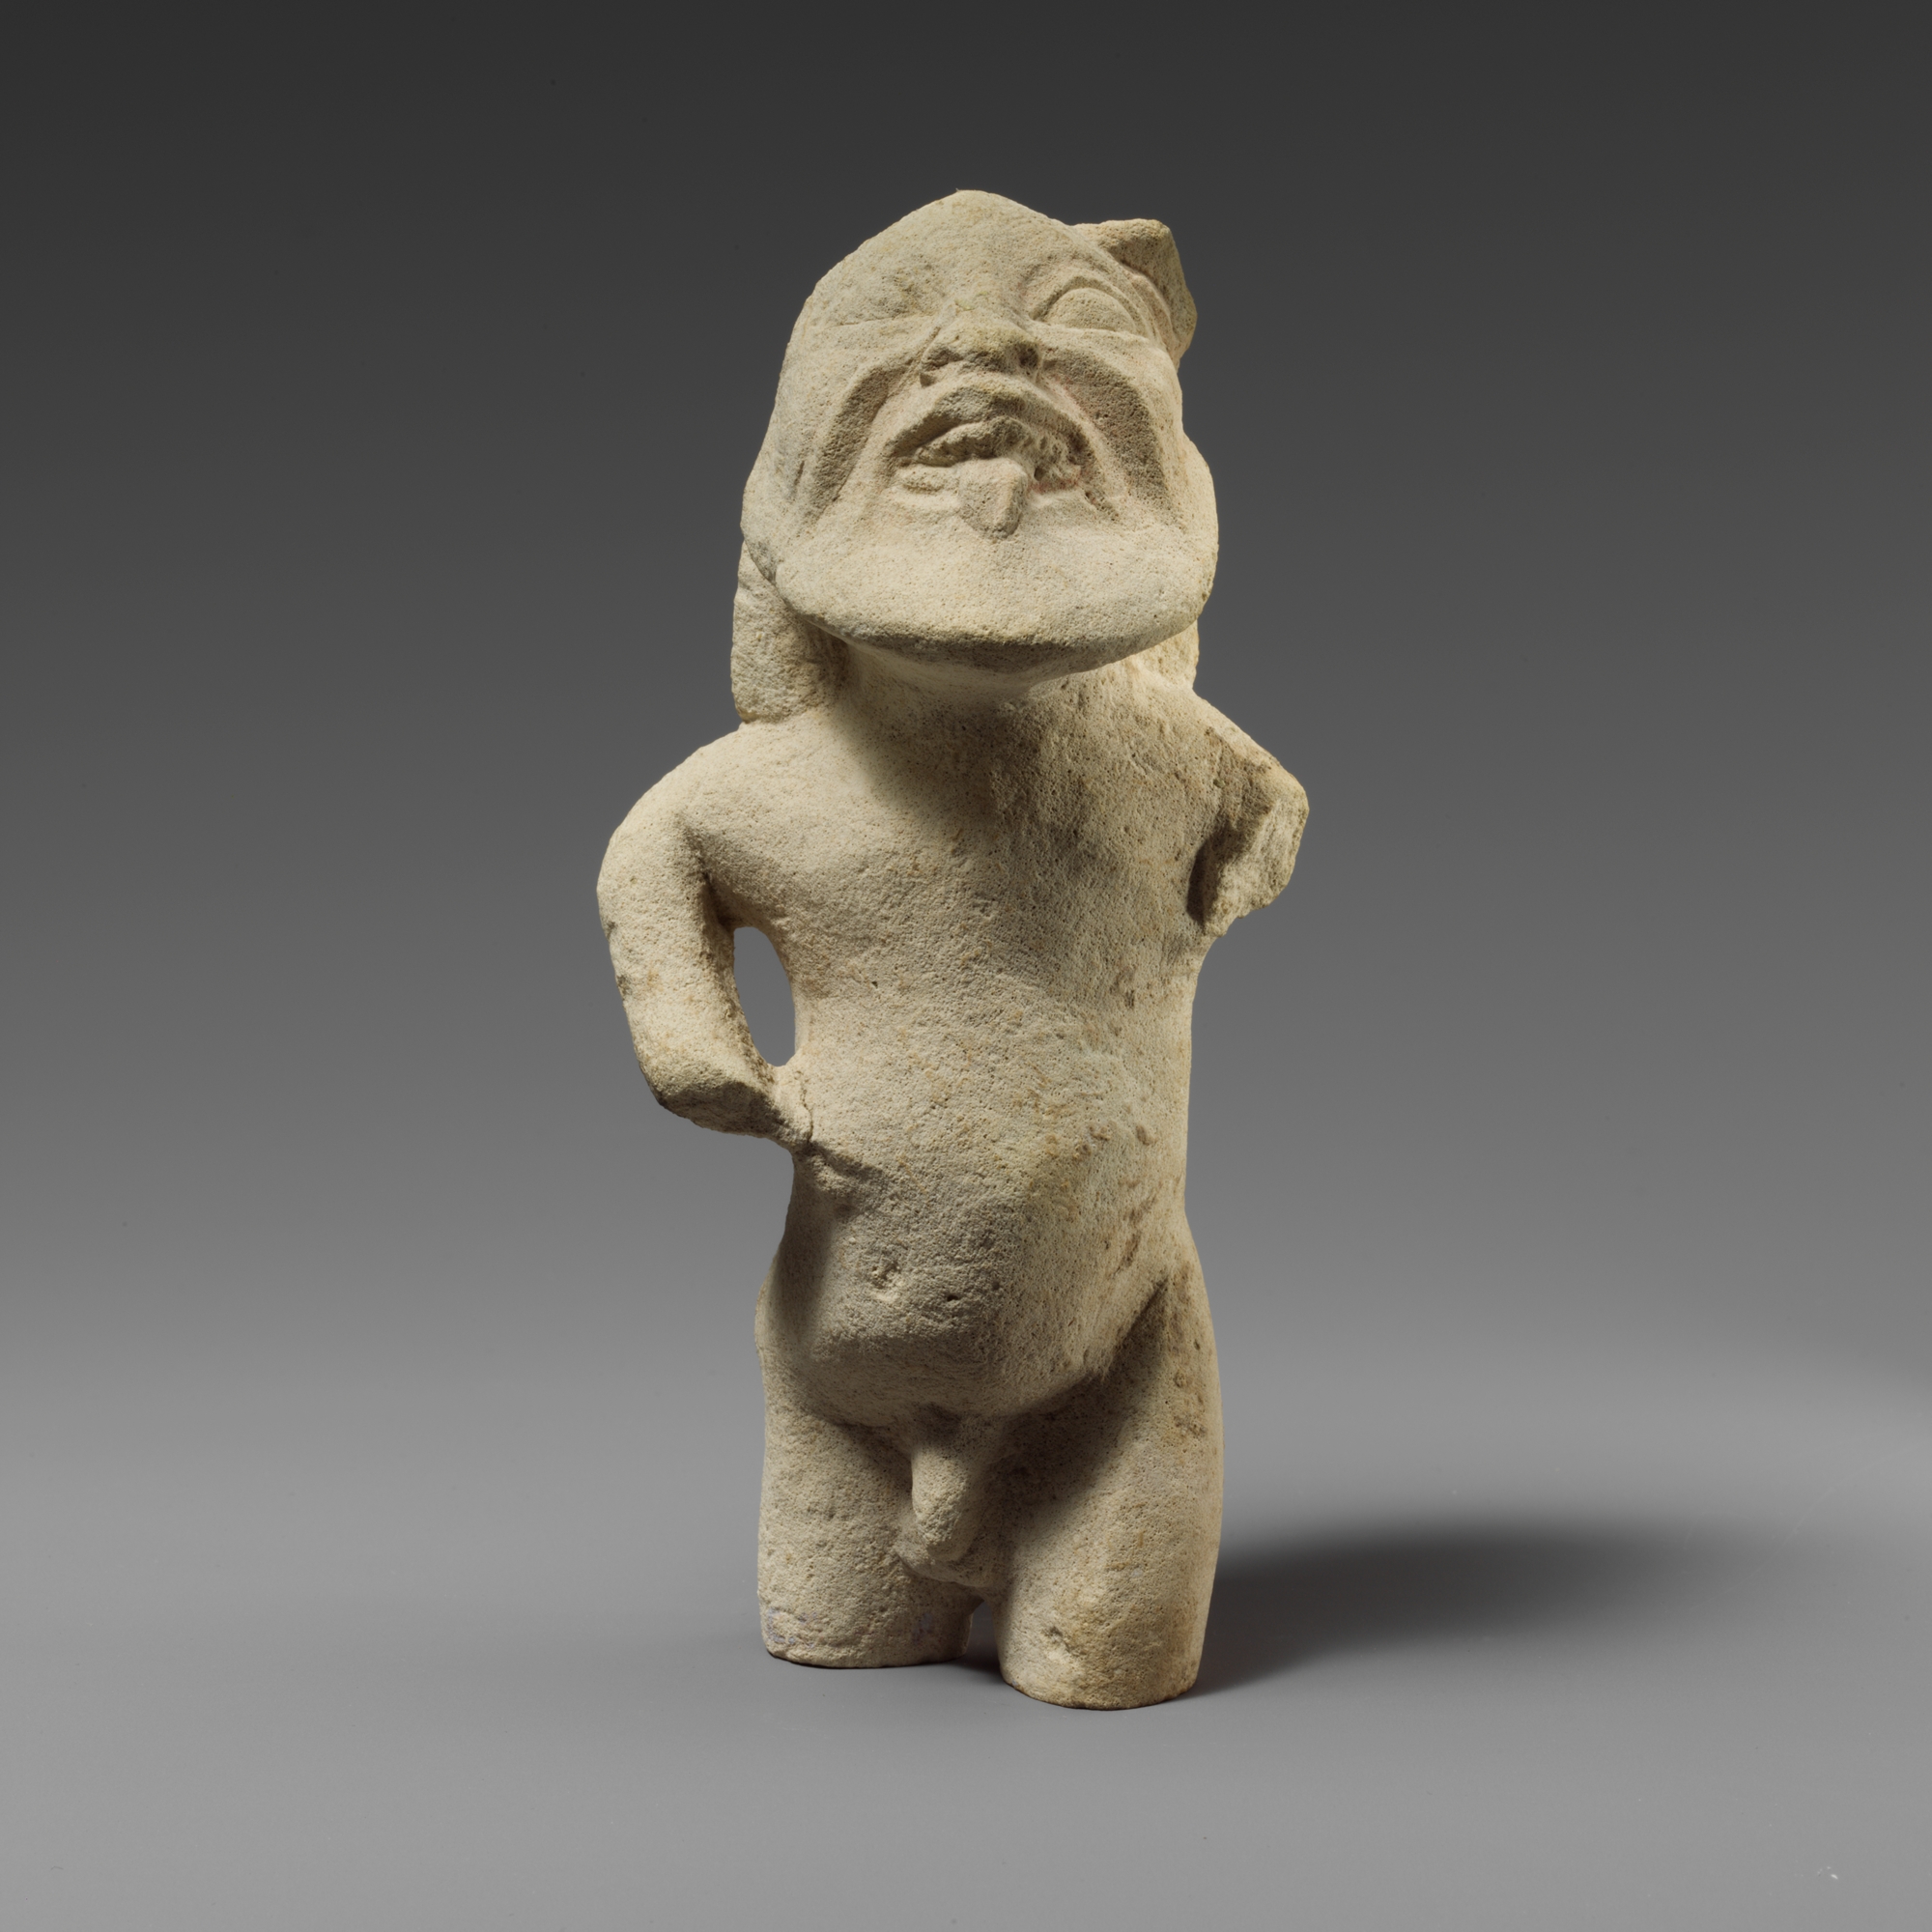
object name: statuette of a satyr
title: Limestone statuette of Bes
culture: cypriot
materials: limestone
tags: bes